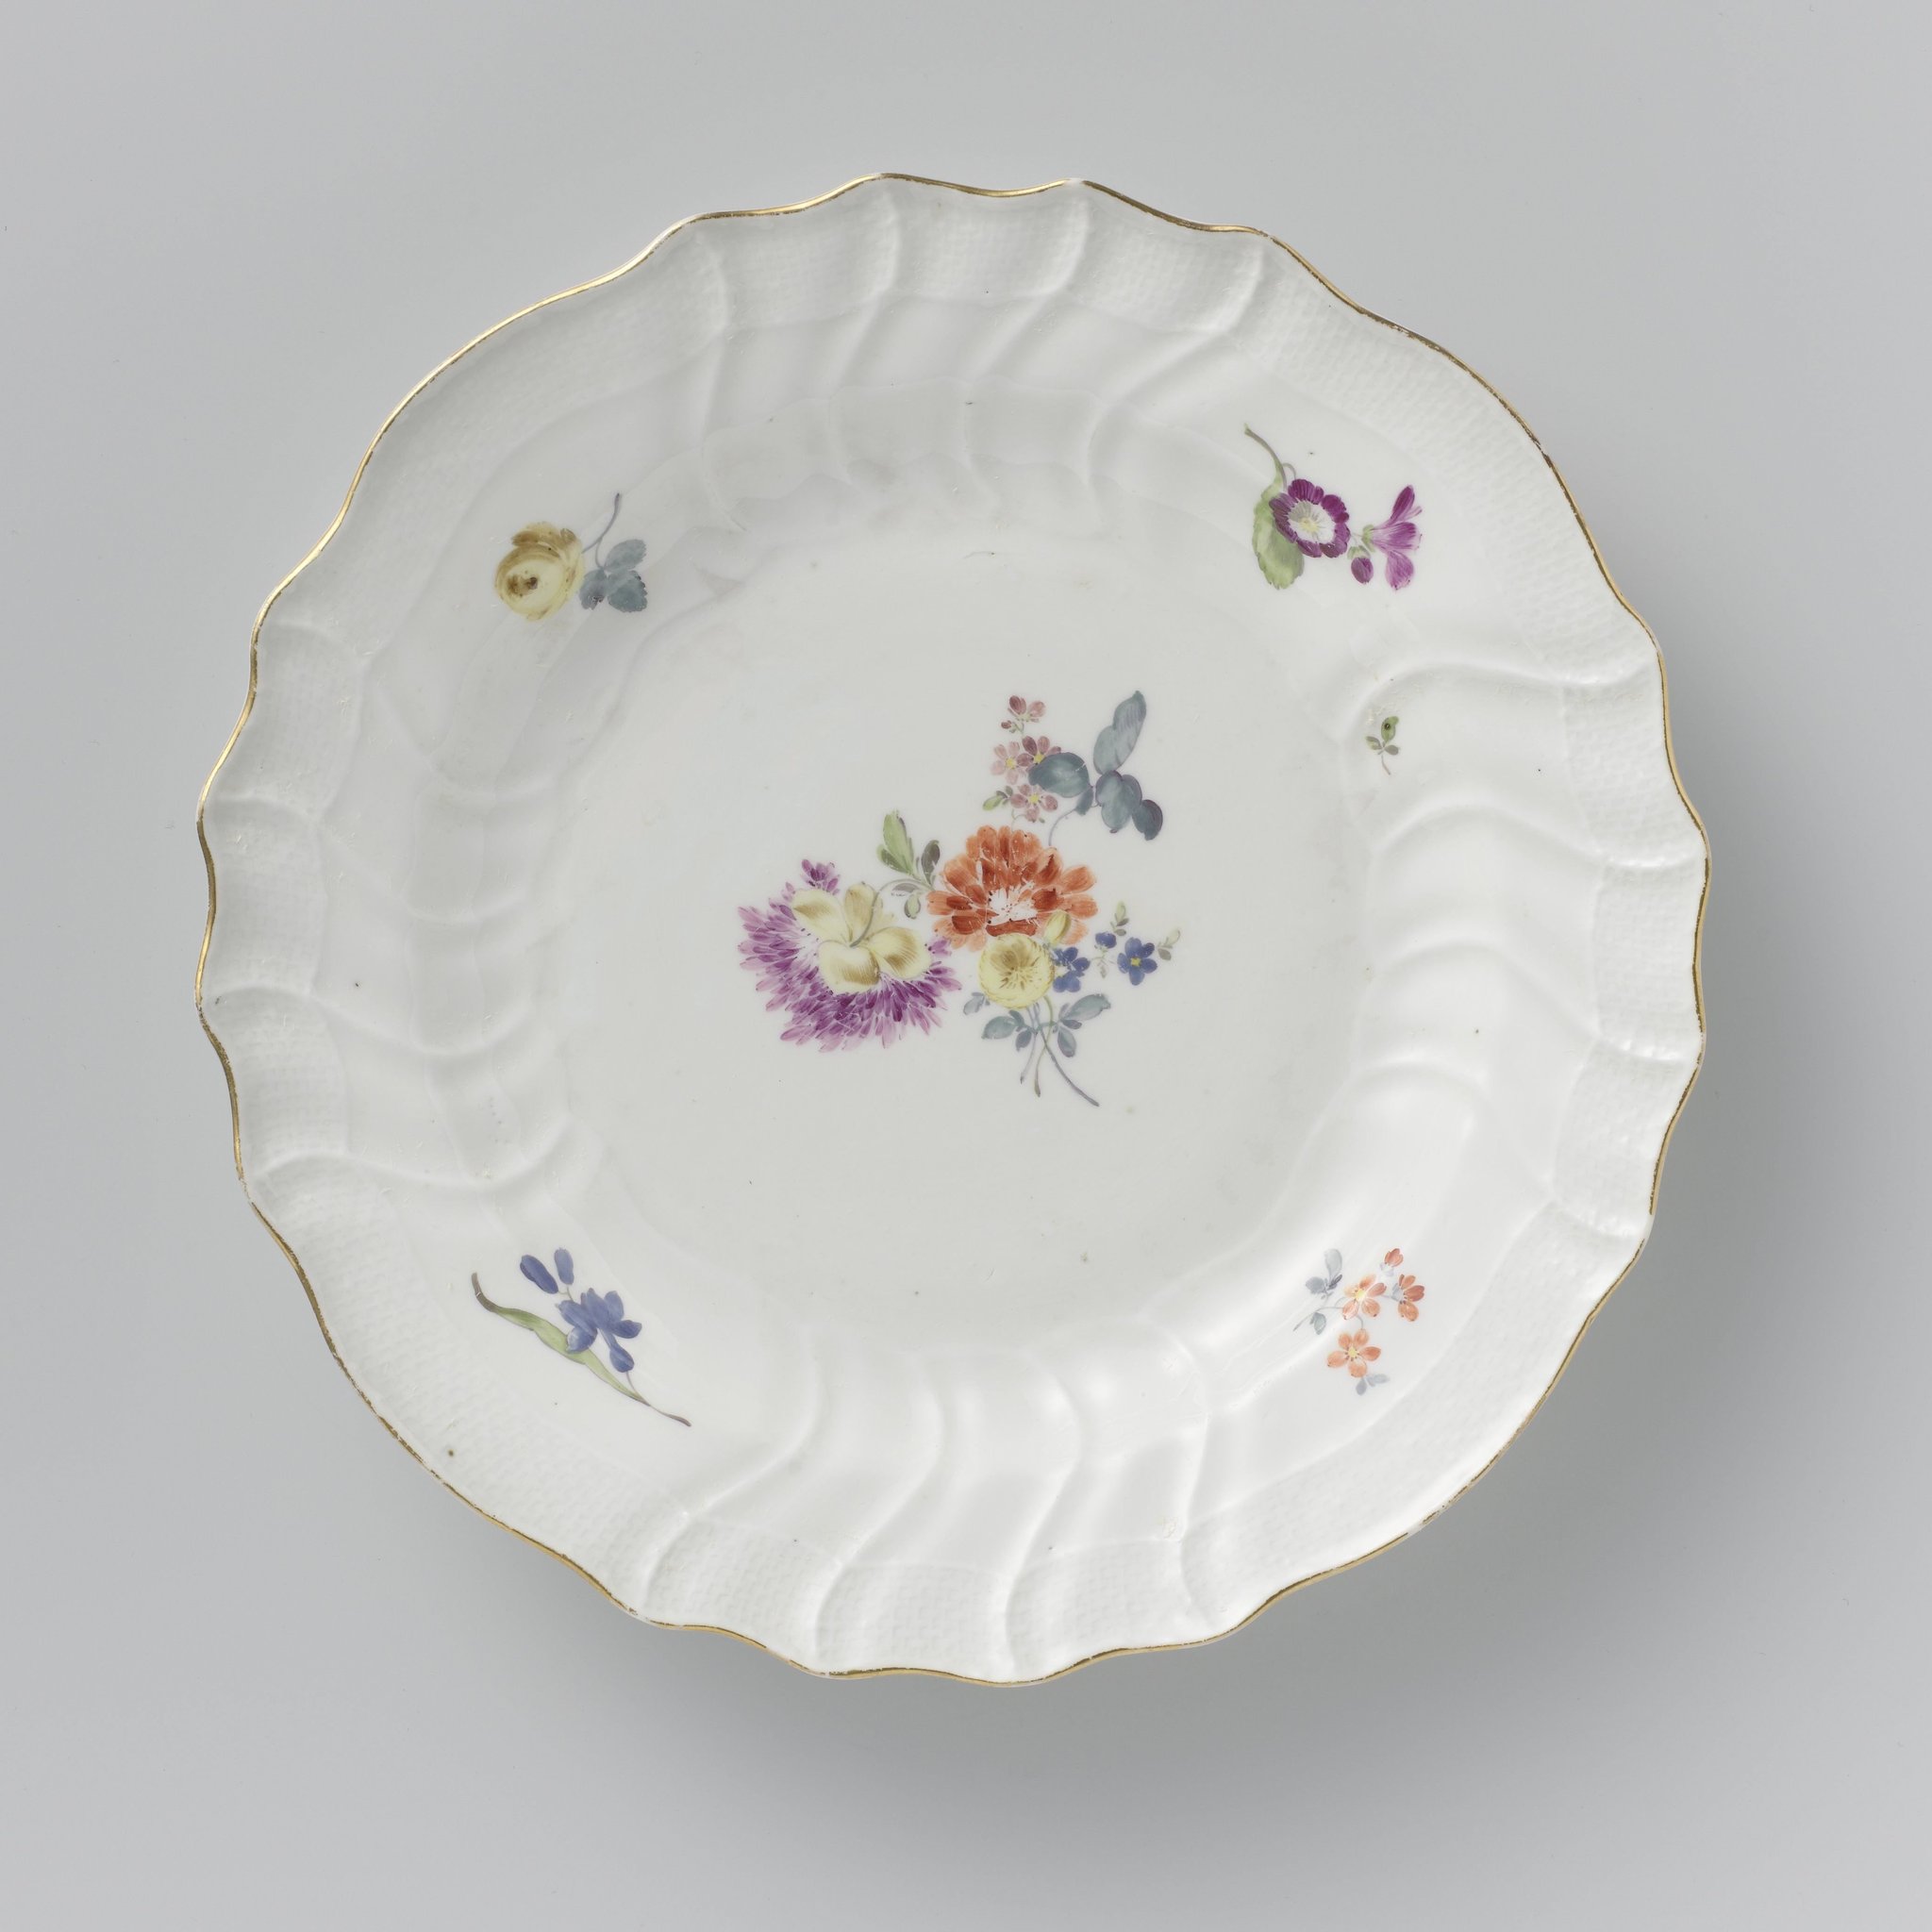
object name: plate dish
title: Bord, veelkleurig beschilderd met Deutsche Blumen, insekten en vruchten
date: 1750-1760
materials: porcelain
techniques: painted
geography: meissen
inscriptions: factory mark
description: Rond bord van beschilderd porselein. Het bord is beschilderd met Deutsche Blumen, insekten en vruchten. De rand is in reliëf versierd met het Neuozier-patroon. Het bord is gemerkt en hoort bij een servies (BK-17474-1 t/m BK-17474-253).